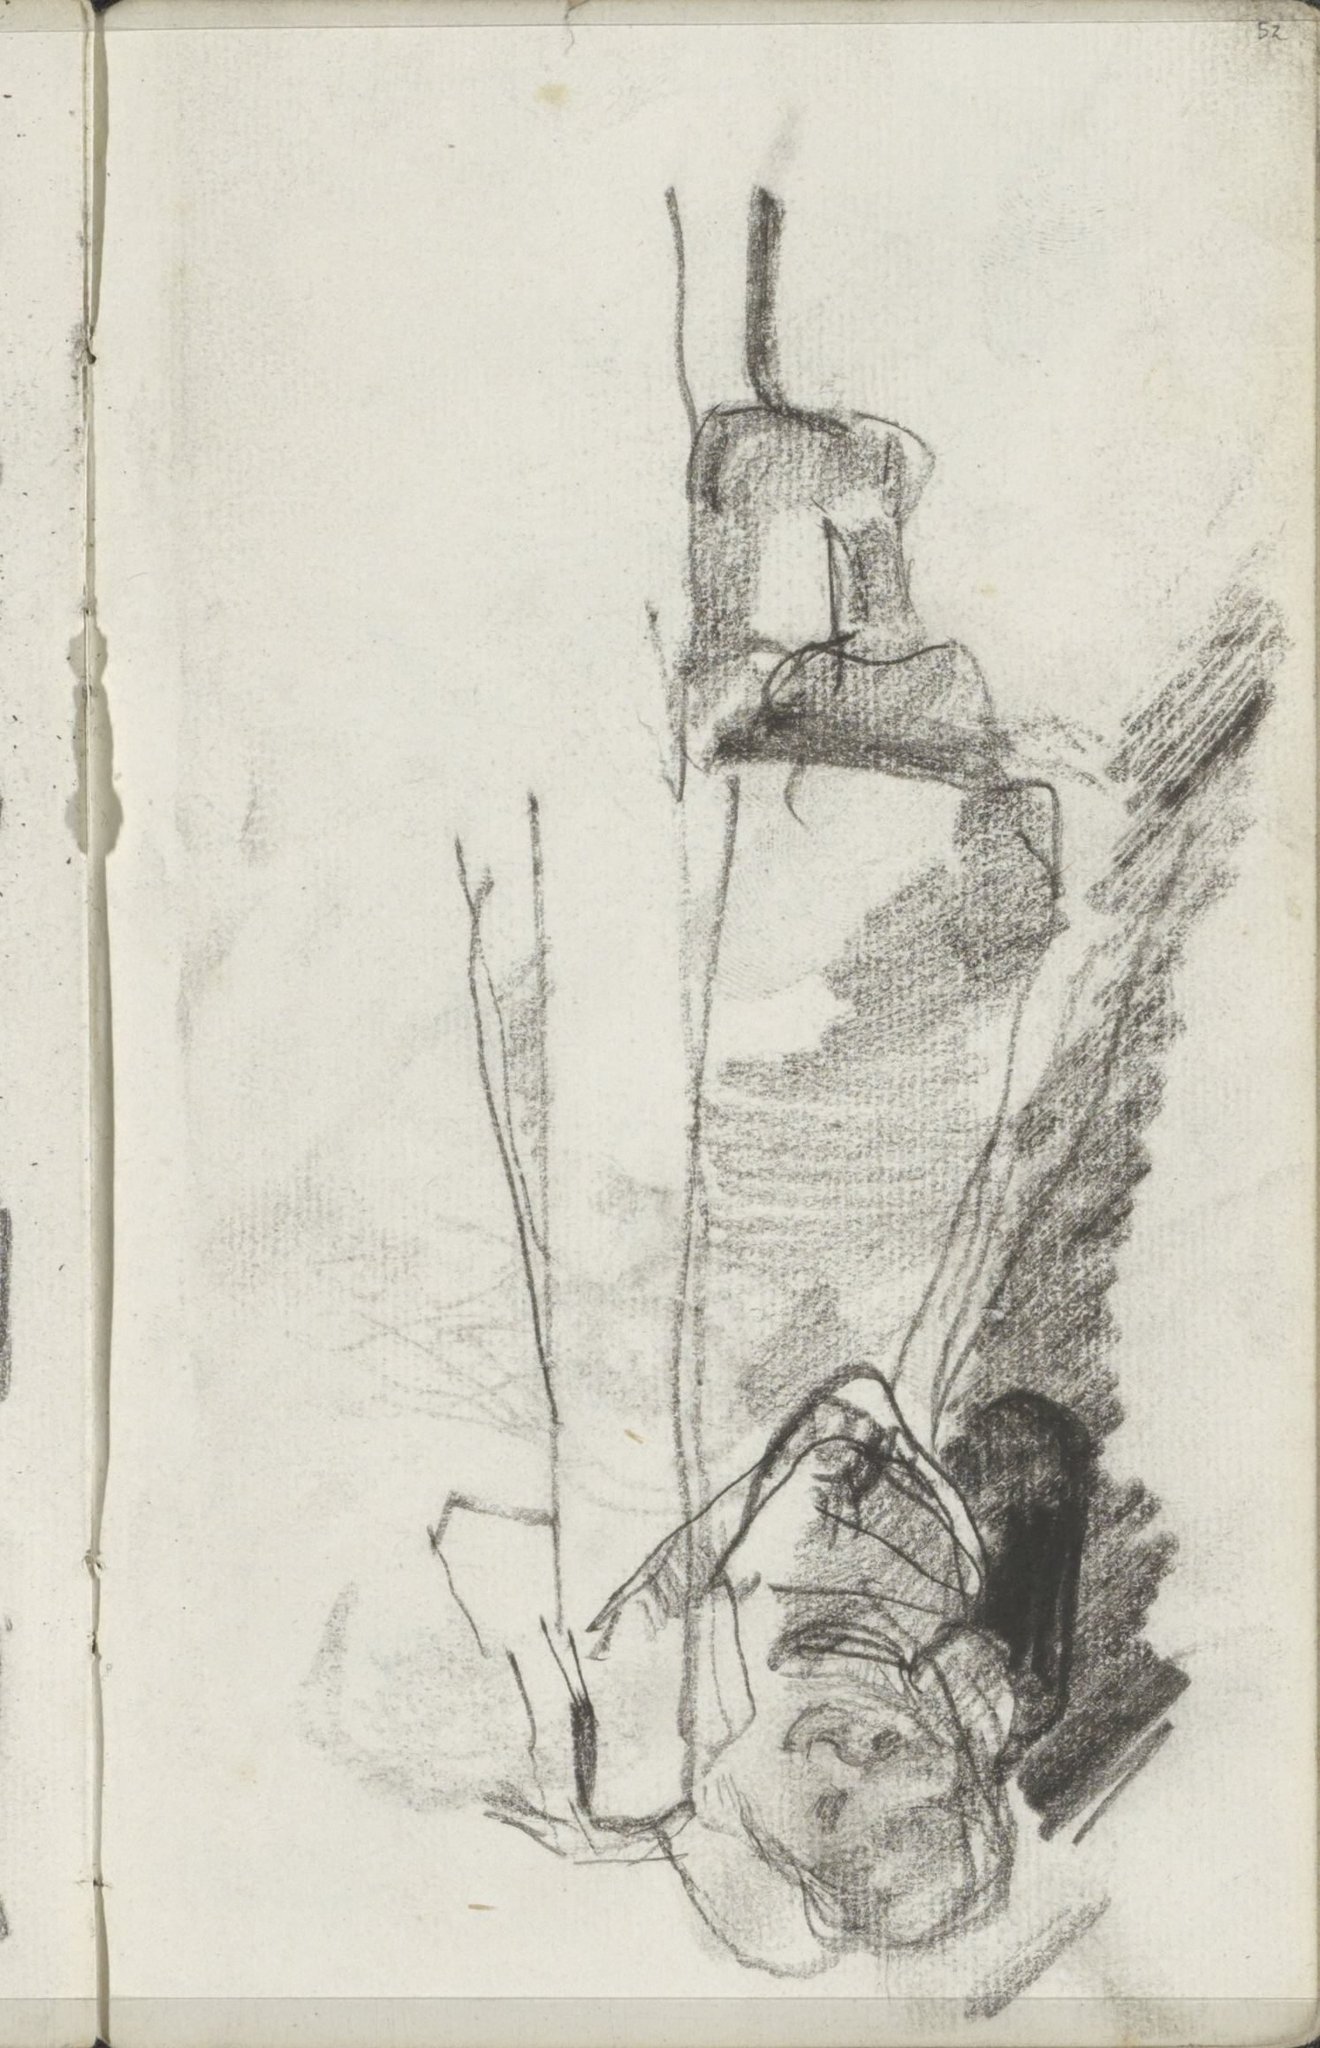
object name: sketchbook leaf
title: Staand meisje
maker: george hendrik breitner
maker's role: draughtsman, painter, print maker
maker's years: 1857-1923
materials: chalk, paper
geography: the hague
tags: girl (child between toddler and youth)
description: Pagina 52 uit een schetsboek met 28 bladen.